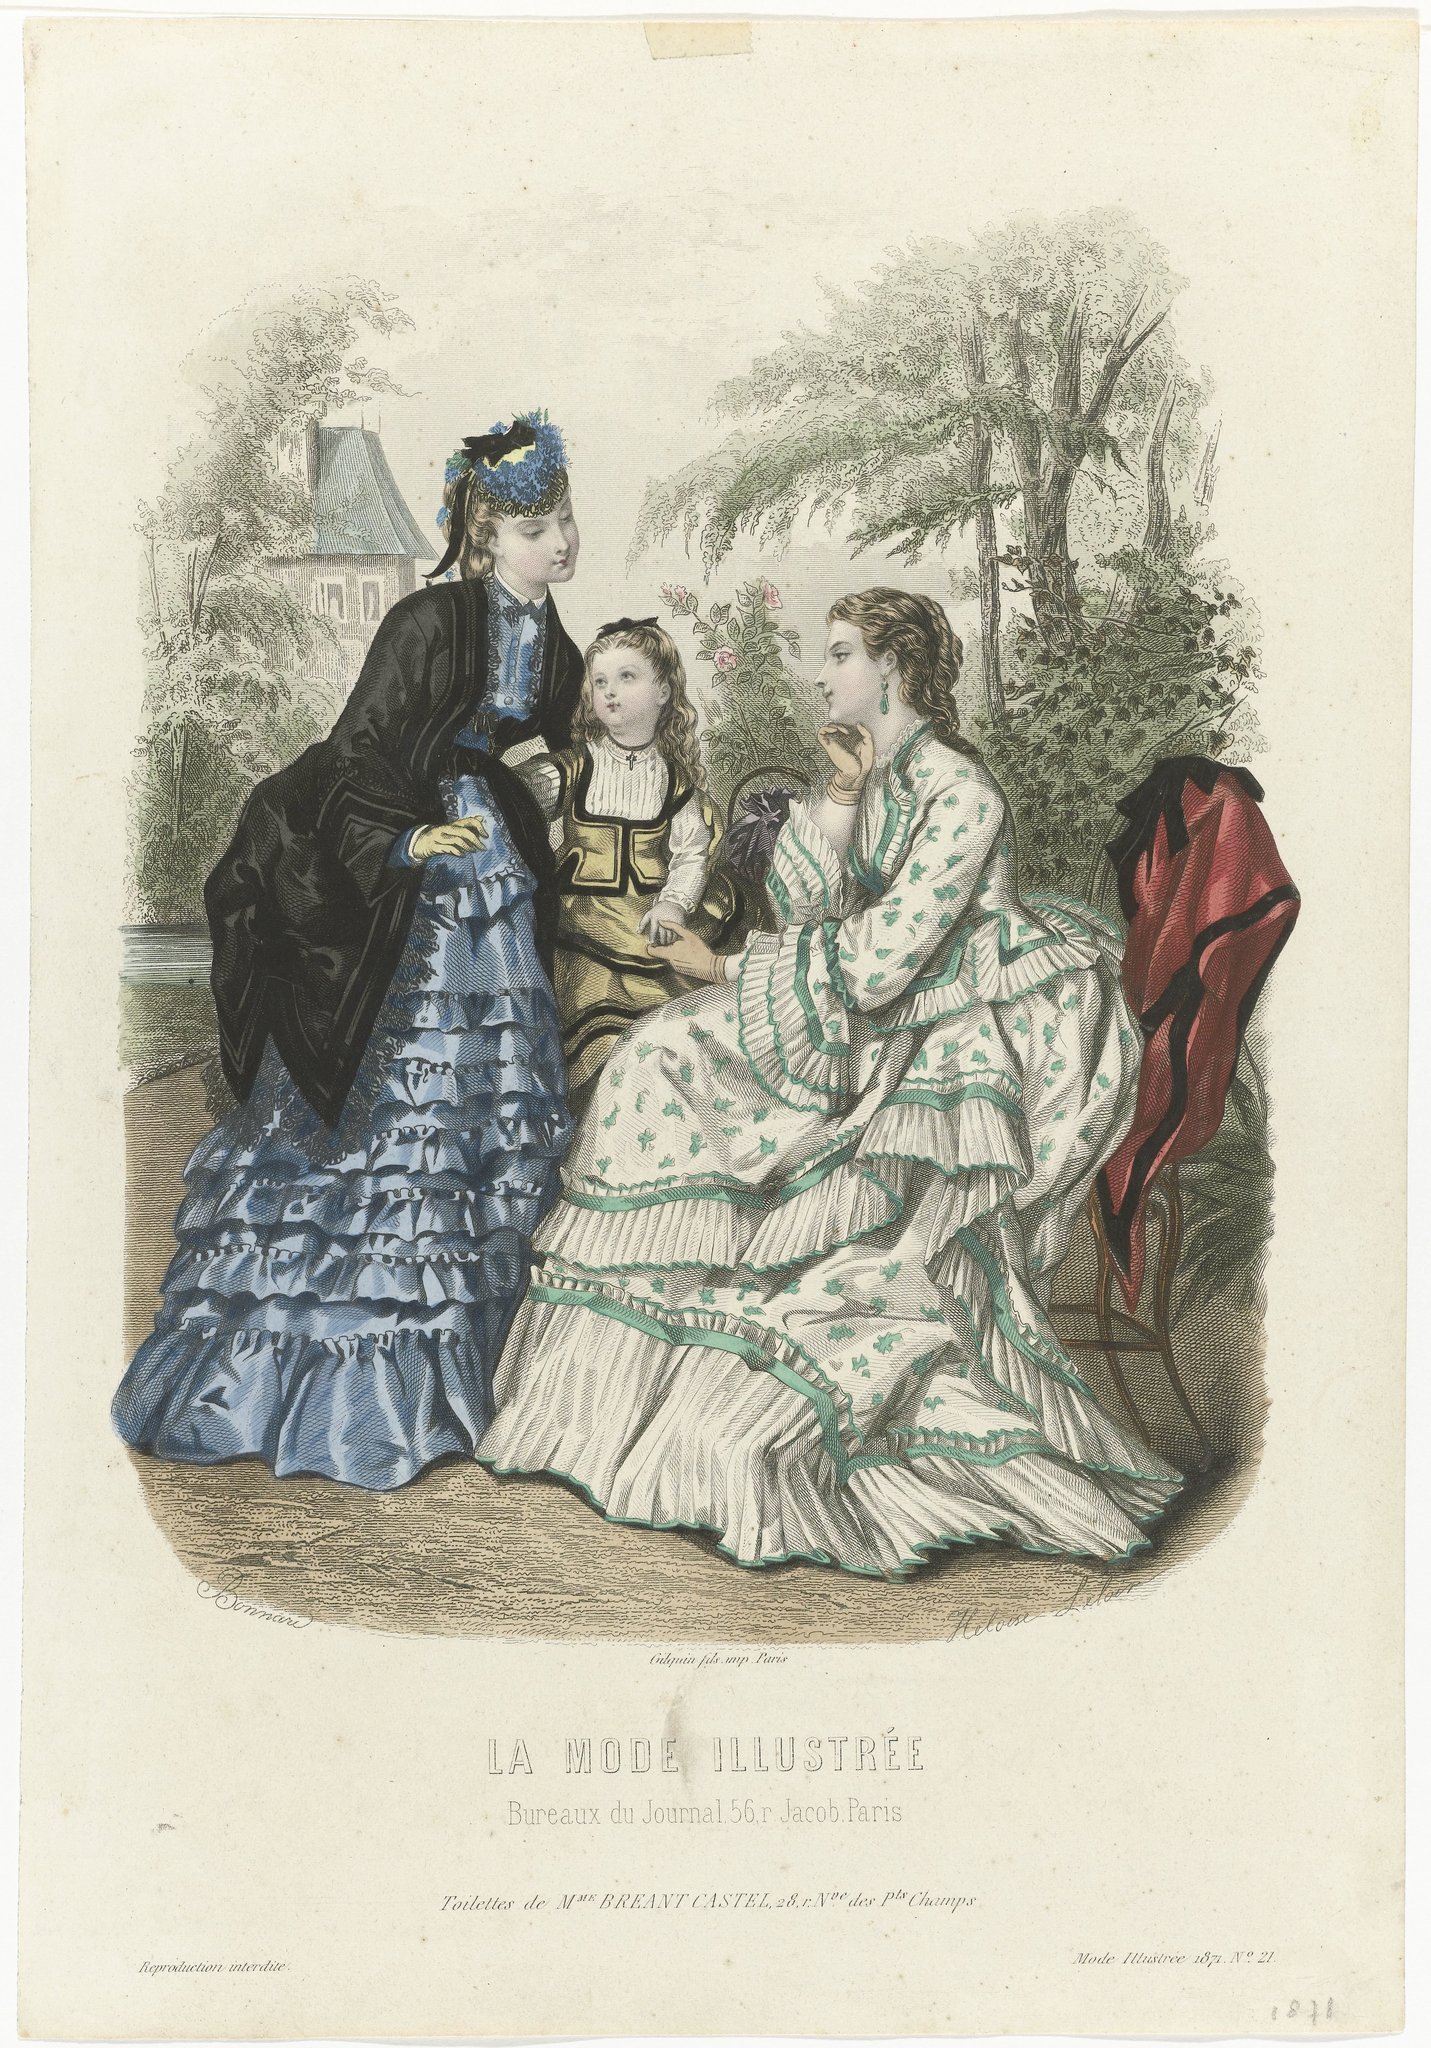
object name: fashion print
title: La Mode Illustrée, 1871, No. 21: Toilettes de Mme Breant Castel (...)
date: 1871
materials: paper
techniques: engraving, hand coloring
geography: paris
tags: ear-rings (+ women's clothes), neck-gear ~ clothing (+ girls' clothes), pendant, trinket, 'breloque' (+ girls' clothes), coat (+ women's clothes), head-gear (+ women's clothes), fashion plates, gloves, mittens, etc. (+ women's clothes), dress, gown (+ women's clothes), dress, gown (+ girls' clothes)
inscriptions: address: ‘Bureaux du Journal, 56, r. Jacob. Paris’, title: ‘La Mode Illustrée’, caption: ‘Toilettes de Mme Breant Castel, 28,r. Nva des Pts Champs’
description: Twee vrouwen en een meisje buiten, gekleed in japonnen van Breant Castel. Prent uit het modetijdschrift La Mode Illustrée (1860-1937).